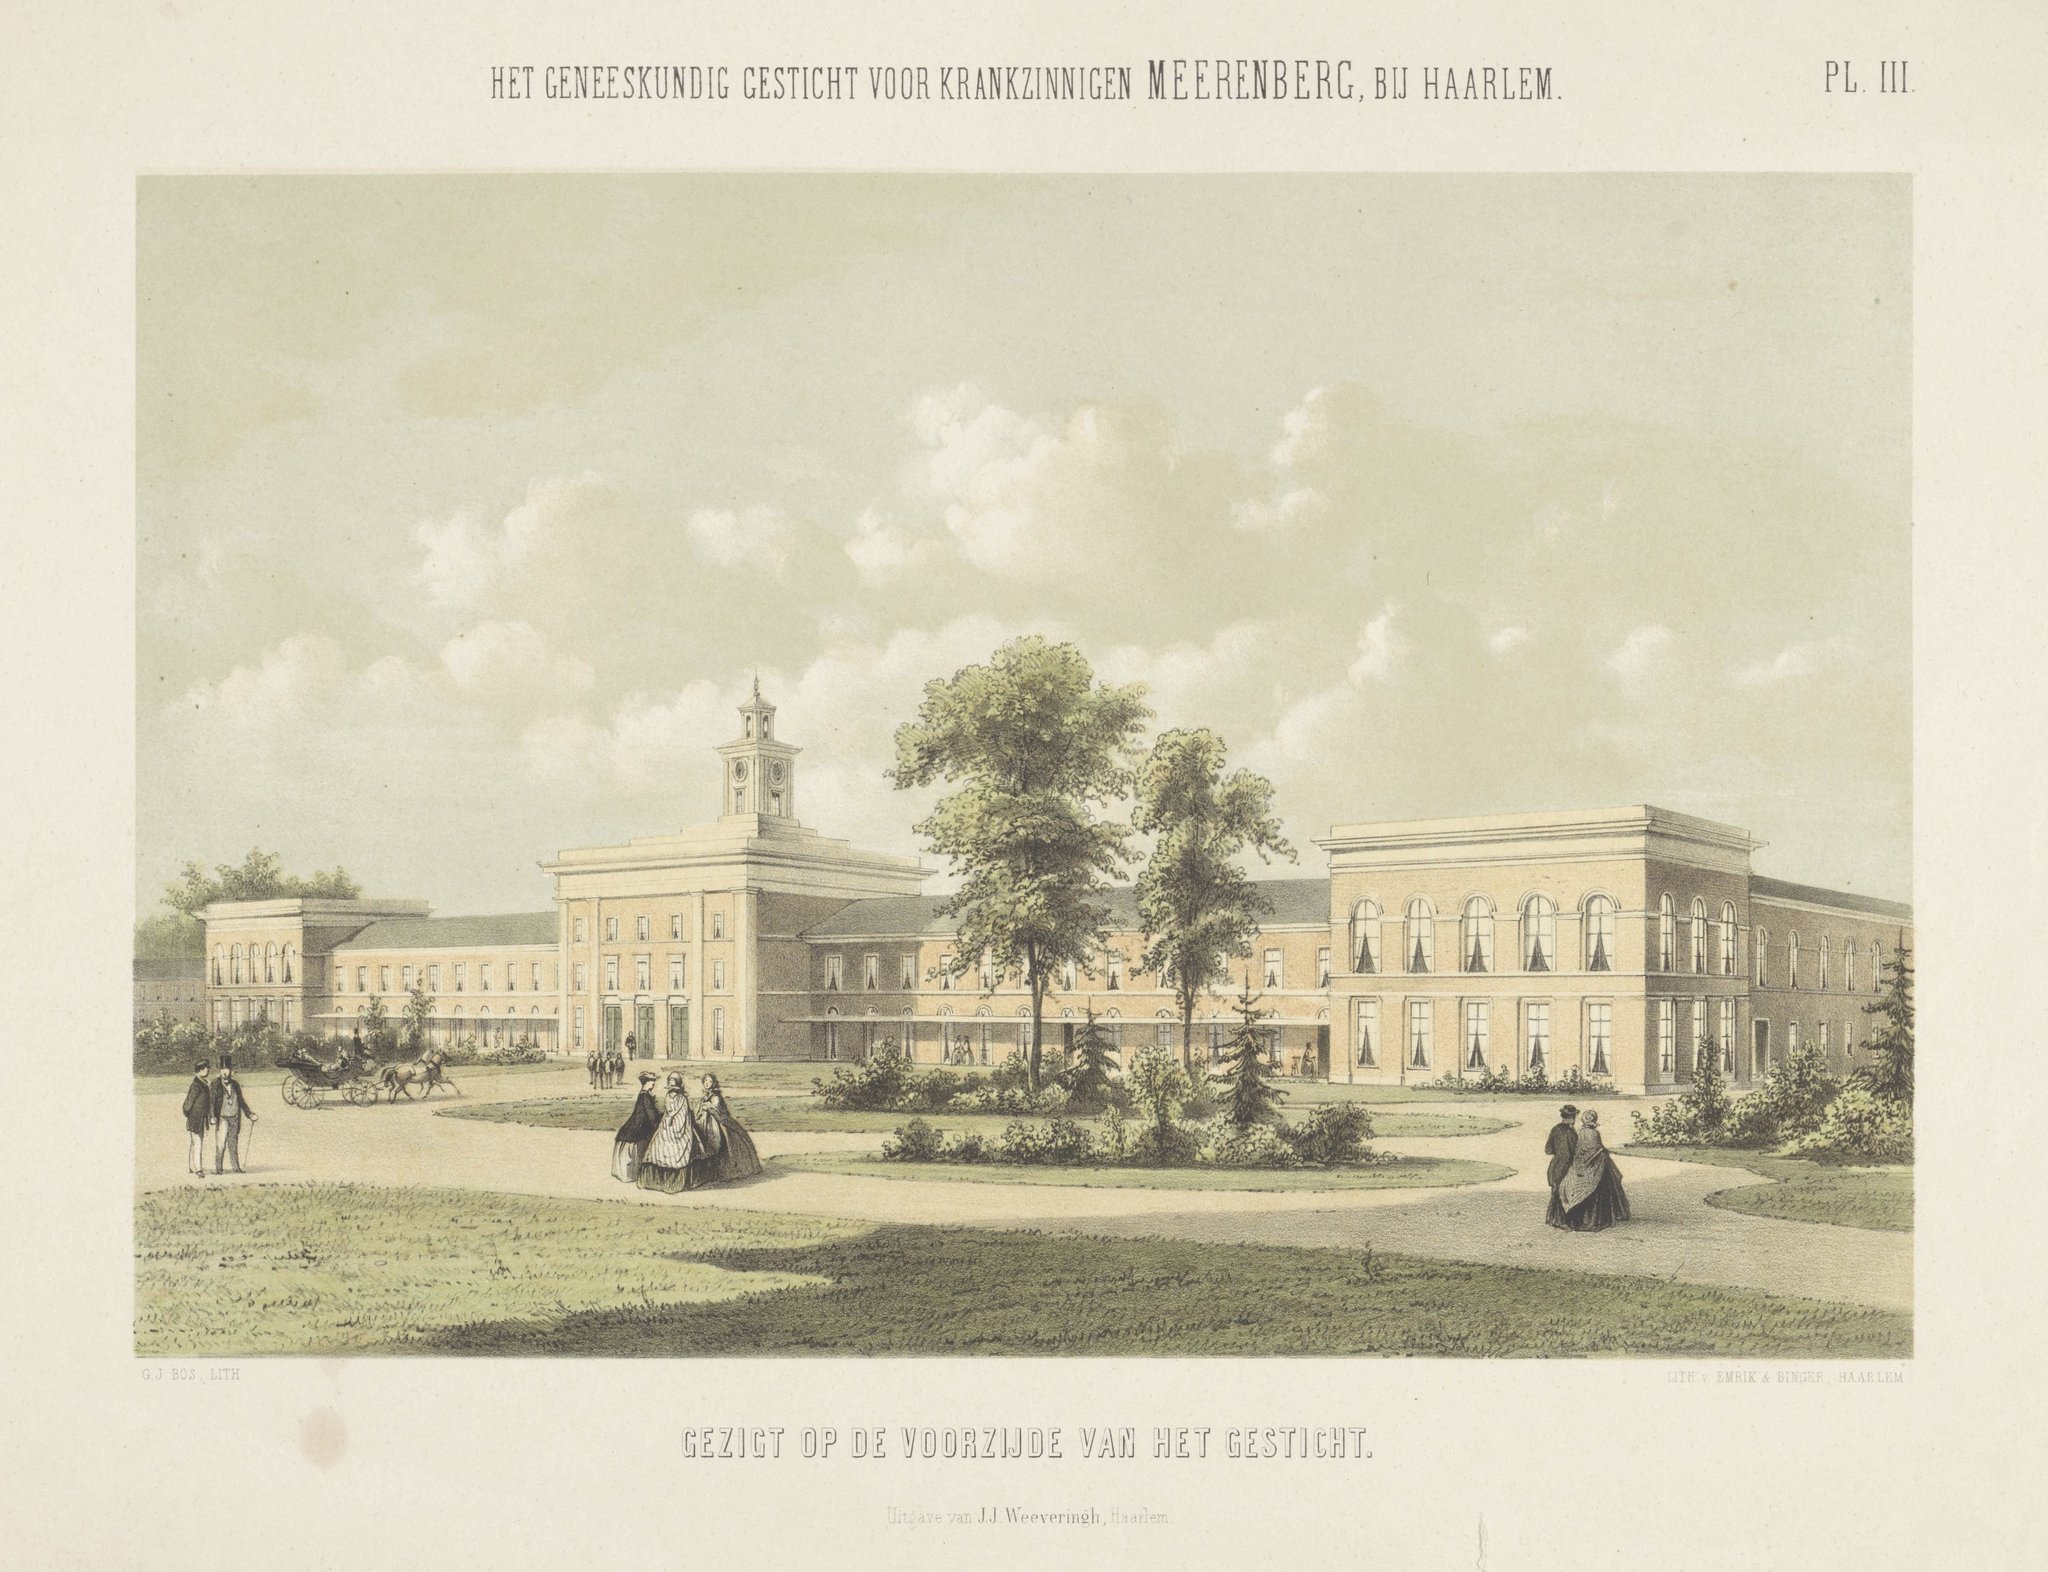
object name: print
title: Psychiatrisch ziekenhuis Meerenberg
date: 1835-1898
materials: paper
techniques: chromolithography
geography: haarlem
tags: hospital, landscapes (+ landscape with figures, staffage)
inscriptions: collector's mark: Lugt 2228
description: Op de weg naar de ingang van het ziekenhuis lopen verschillende figuren en een rijtuig met twee paarden. In het midden voor het gebouw staan twee bomen. Rechtsboven: Pl. III.